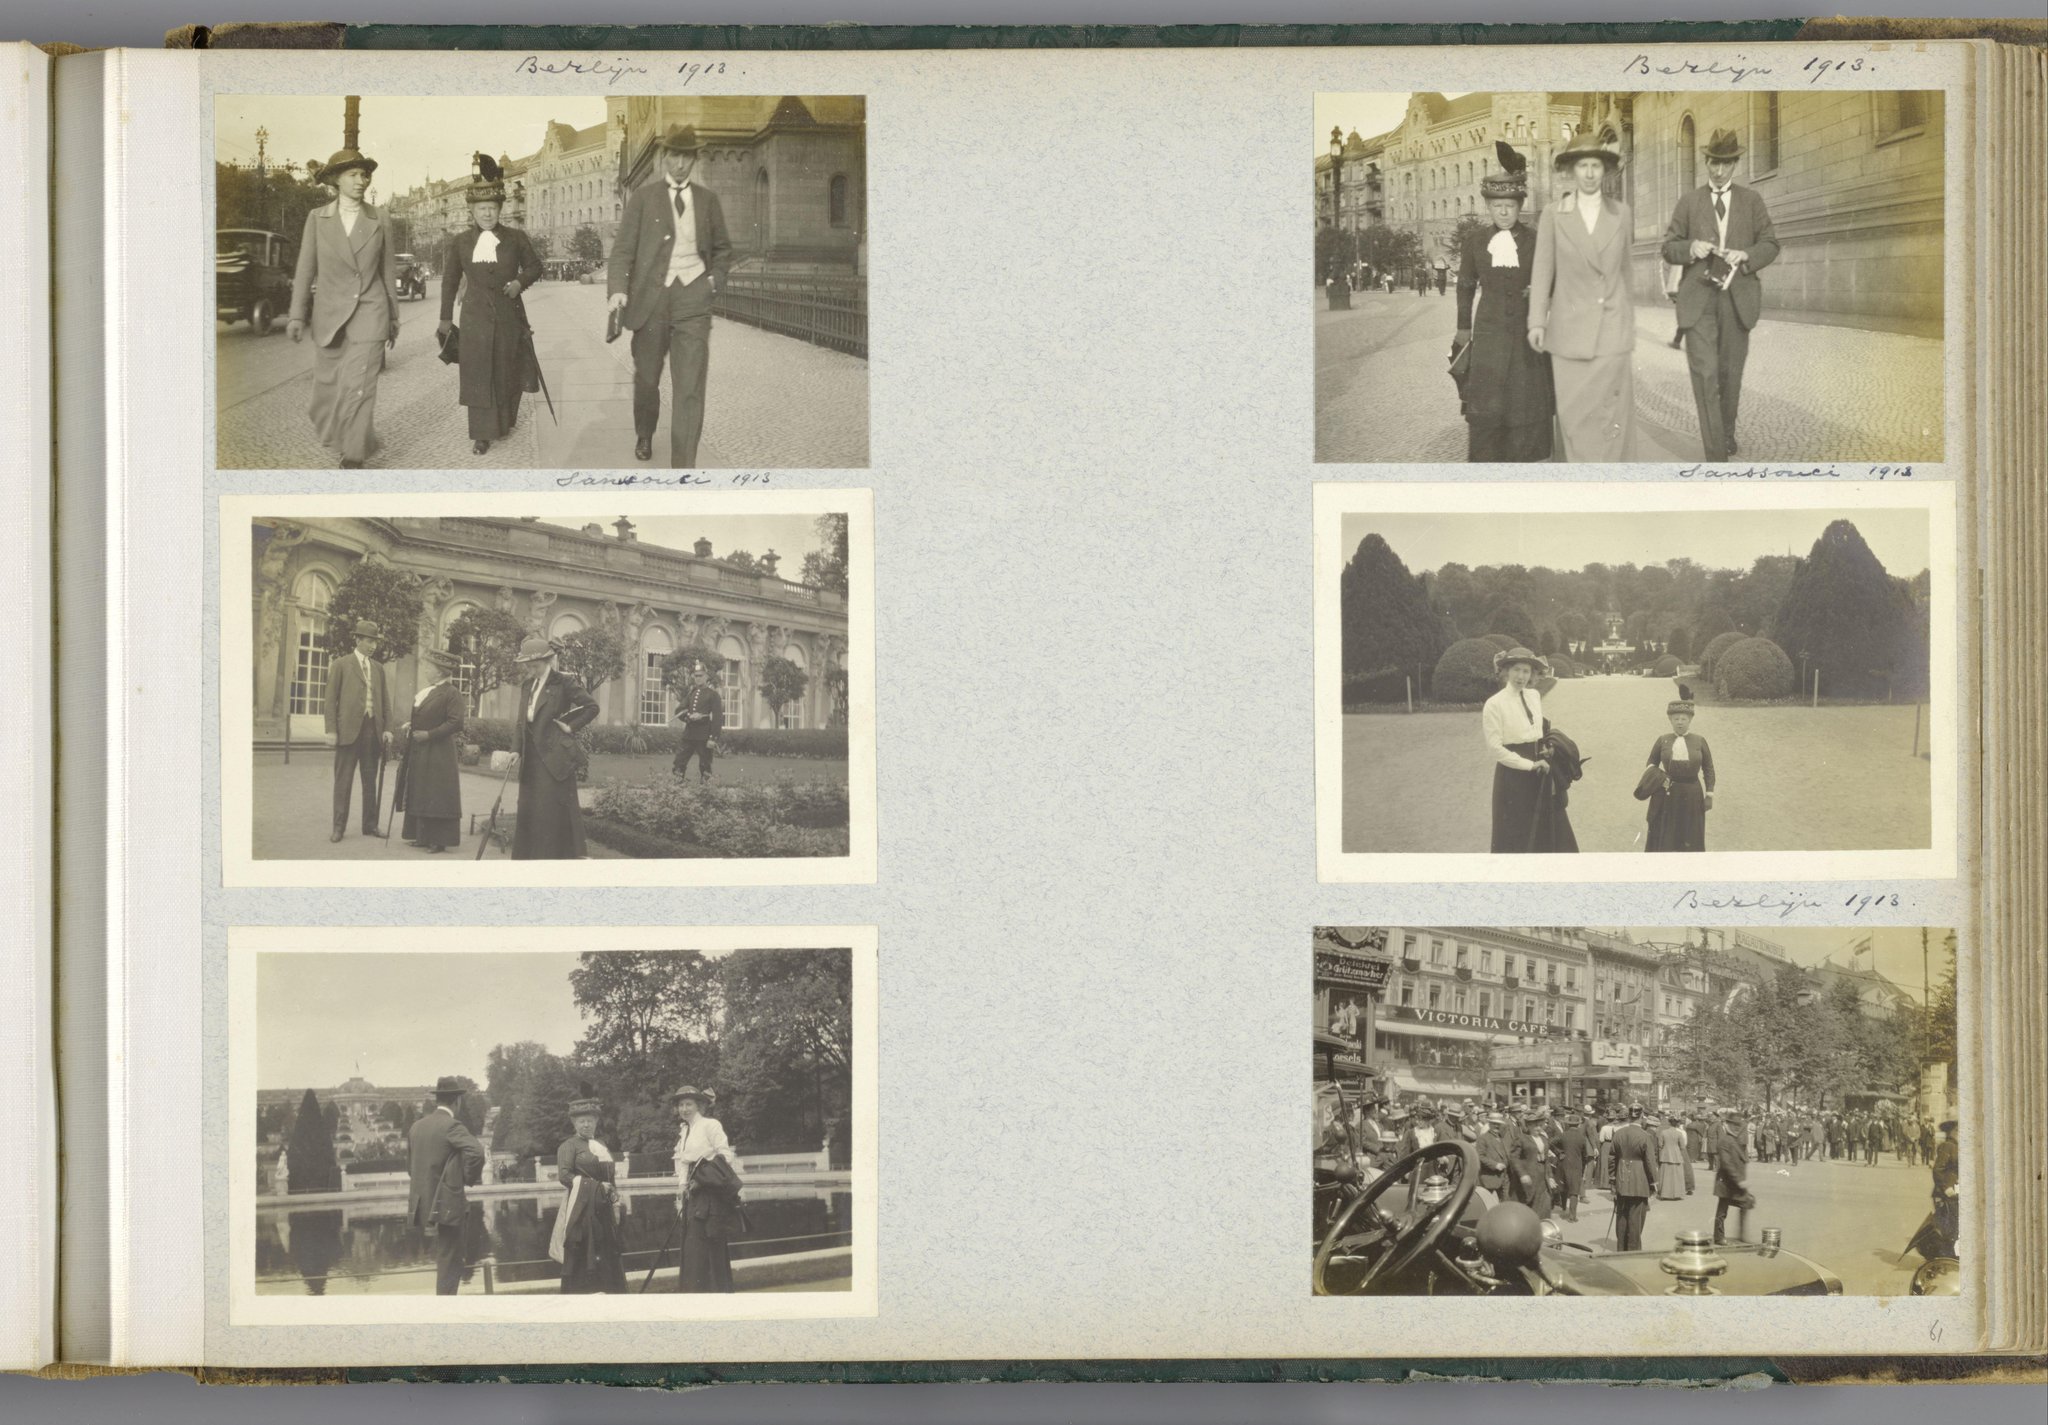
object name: album leaf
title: Albumblad met zes foto's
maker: andries augustus boom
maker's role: amateurfotograaf, handelaar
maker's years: 1878-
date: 1913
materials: paper, photographic support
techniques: photography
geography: berlin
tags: amsterdam, andries augustus boom, berlin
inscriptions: date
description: Albumblad met zes foto's in Berlijn, 1913. Onderdeel van het fotoalbum van de familie Boom-Gonggrijp in Suriname en Curaçao.